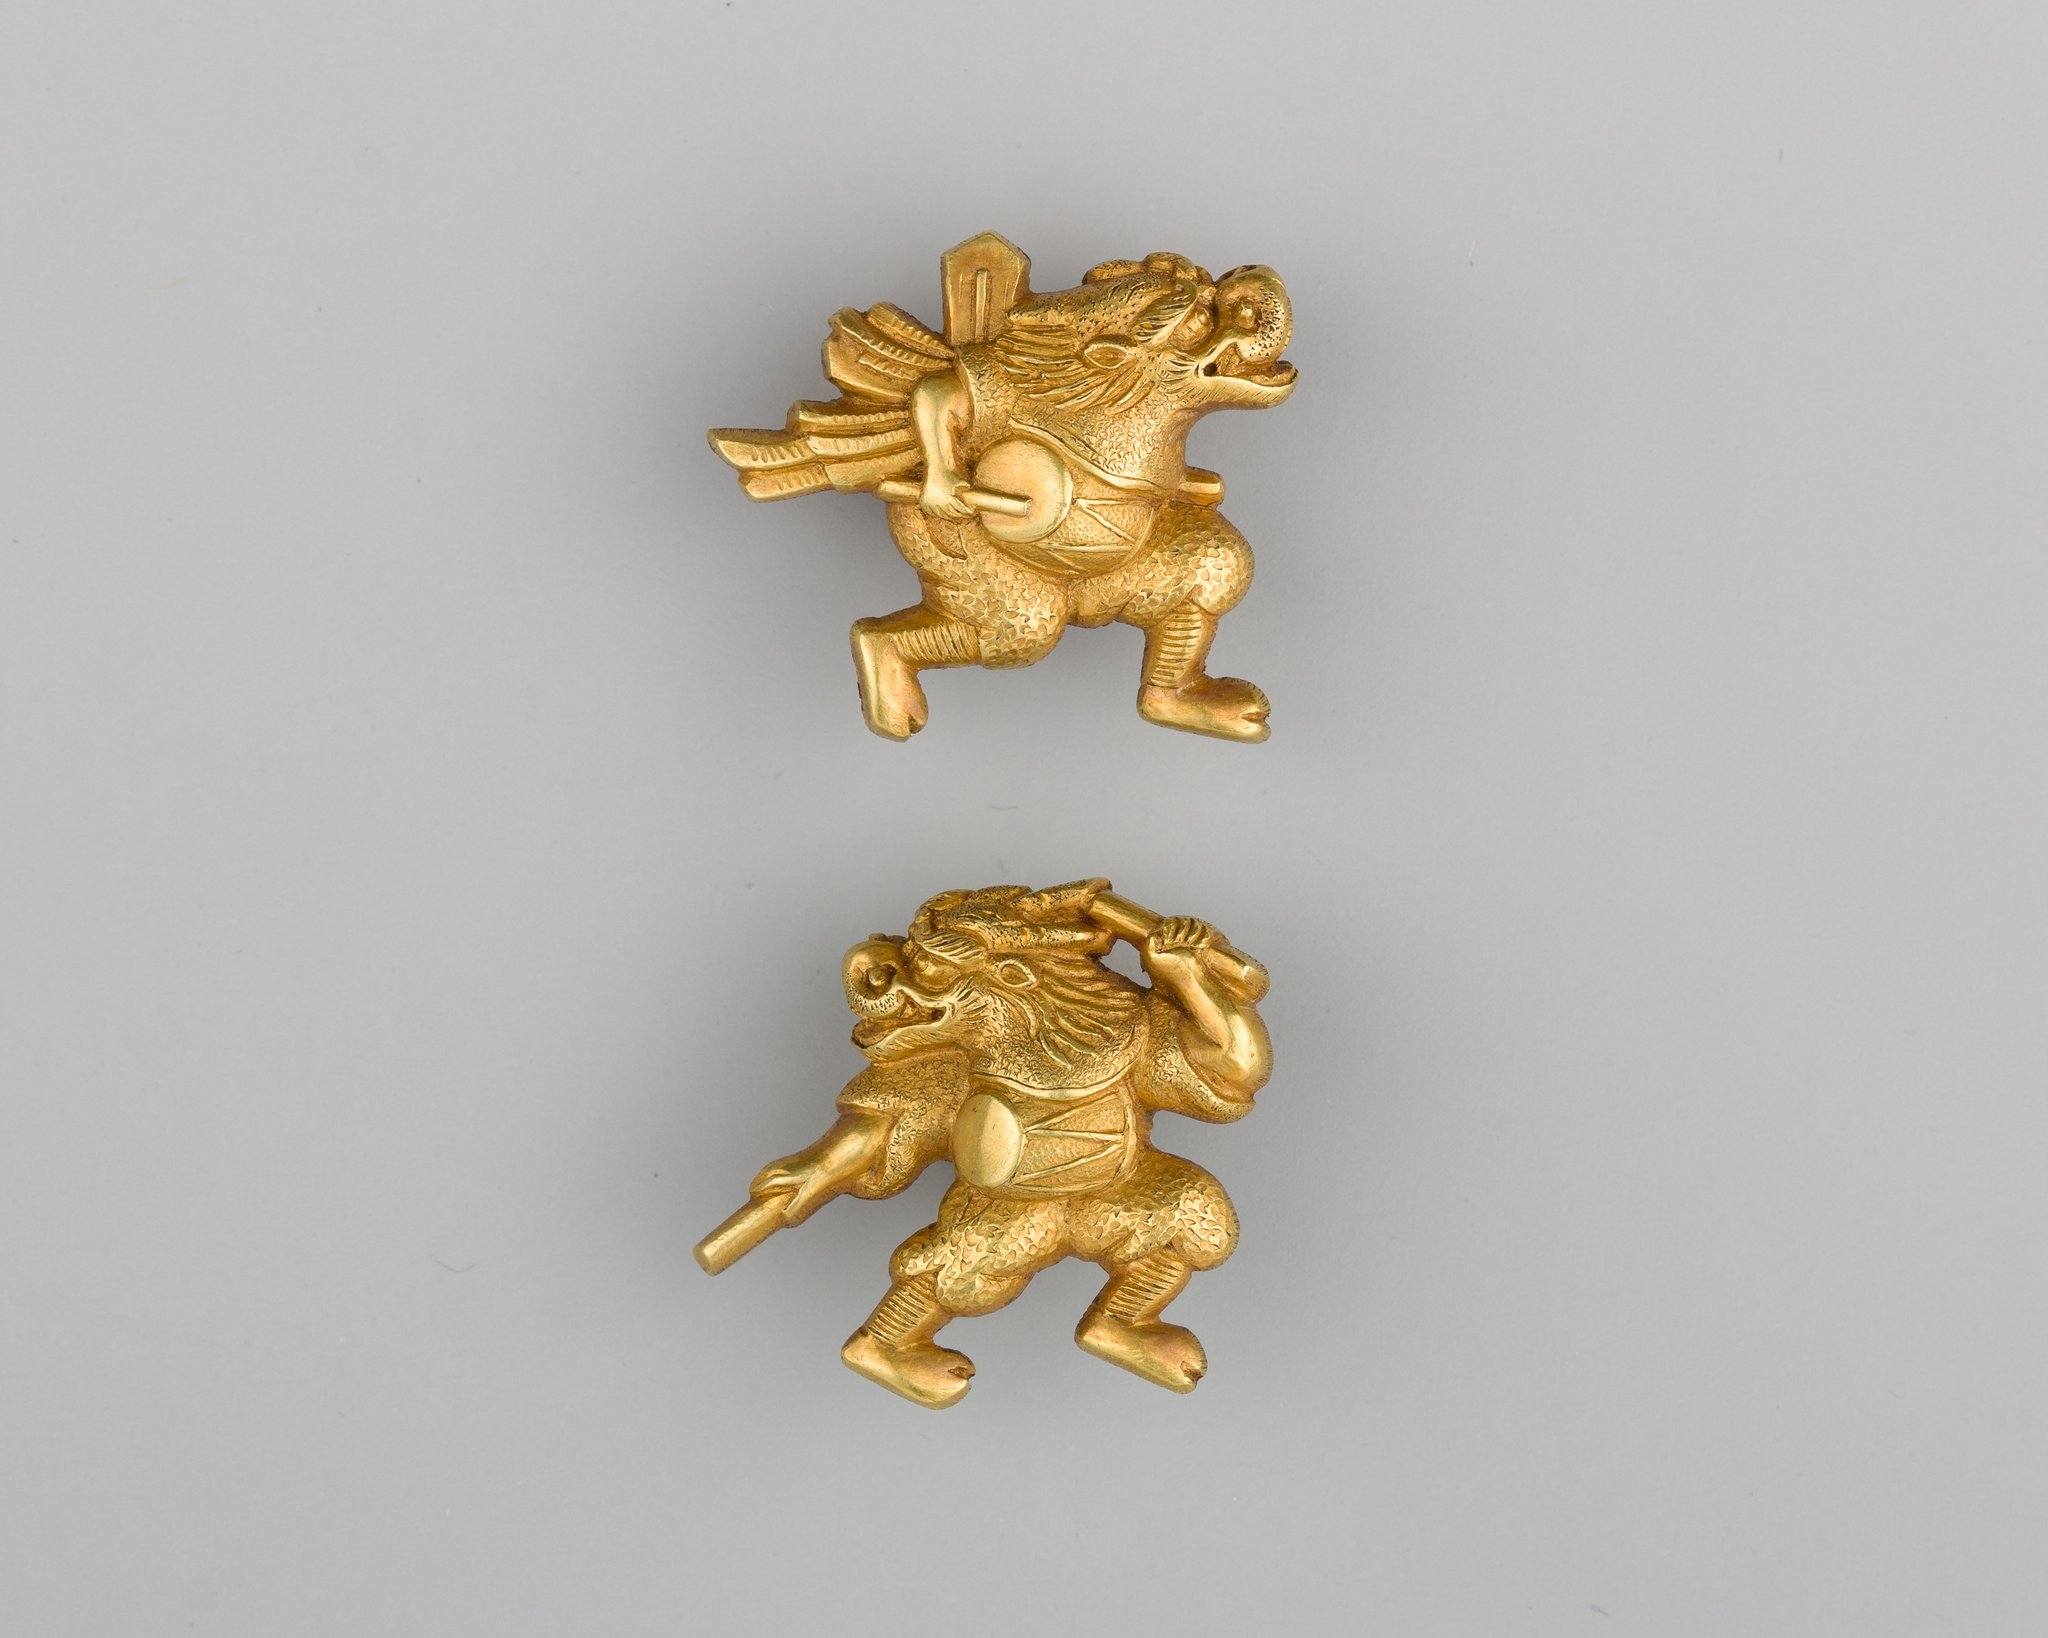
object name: pair of sword grip ornament menuki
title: Pair of Sword-Grip Ornaments (Menuki)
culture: japanese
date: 1701-1800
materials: gold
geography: japan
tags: drums,lions